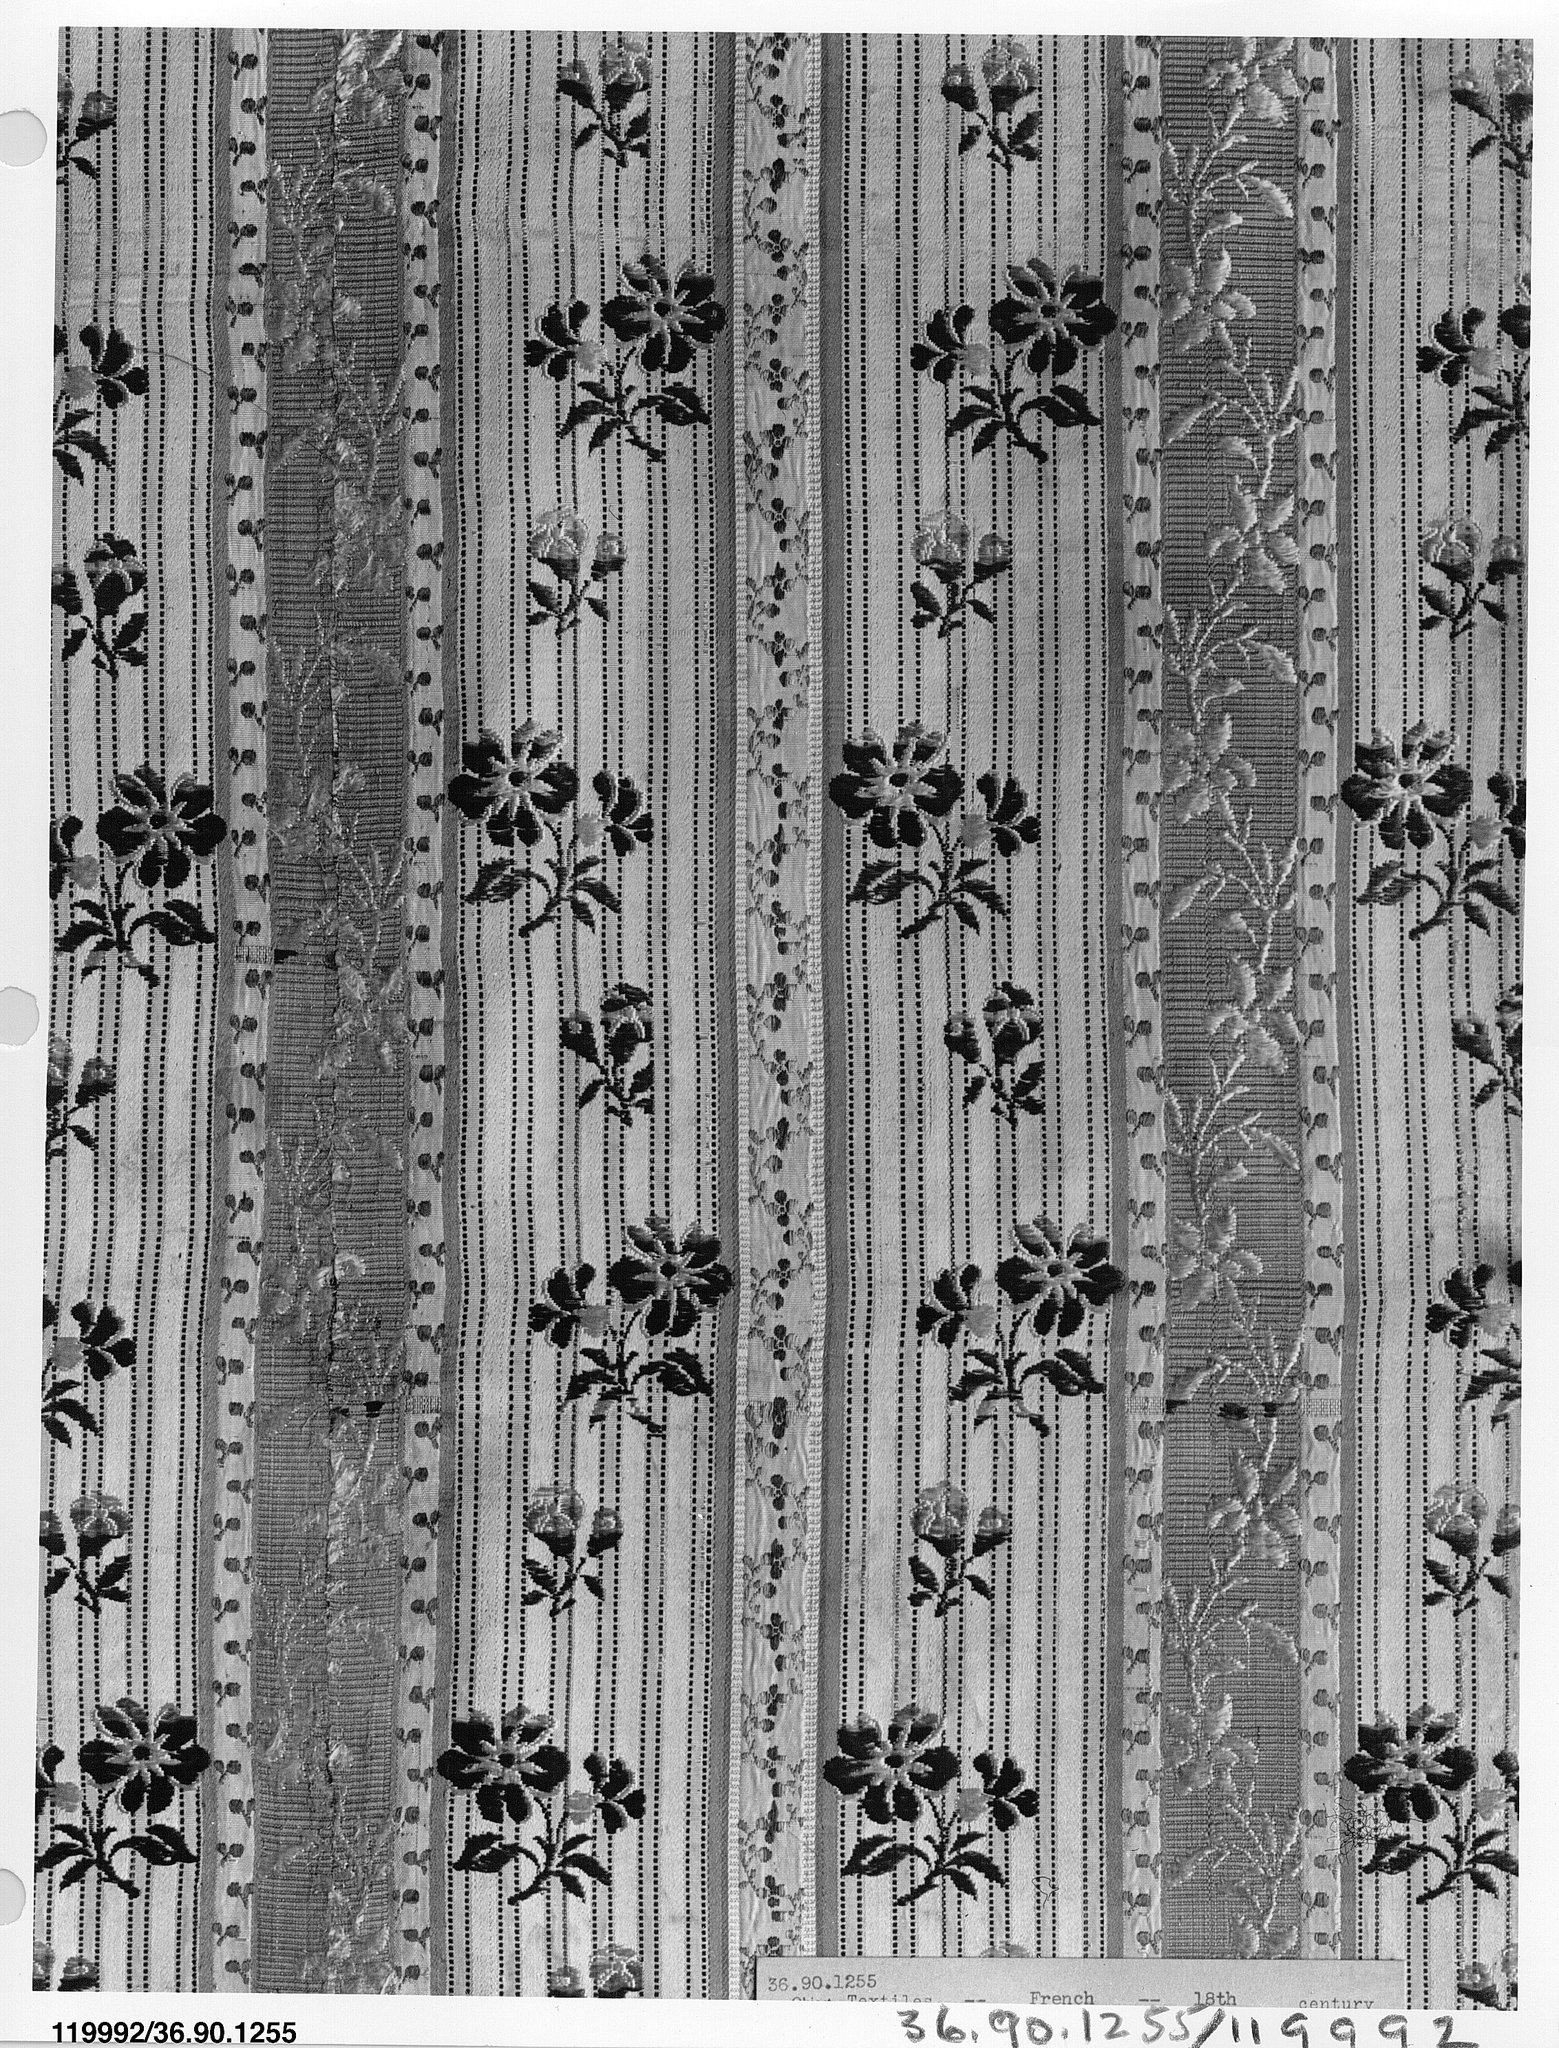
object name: piece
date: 1701-1800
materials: silk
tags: flowers,leaves